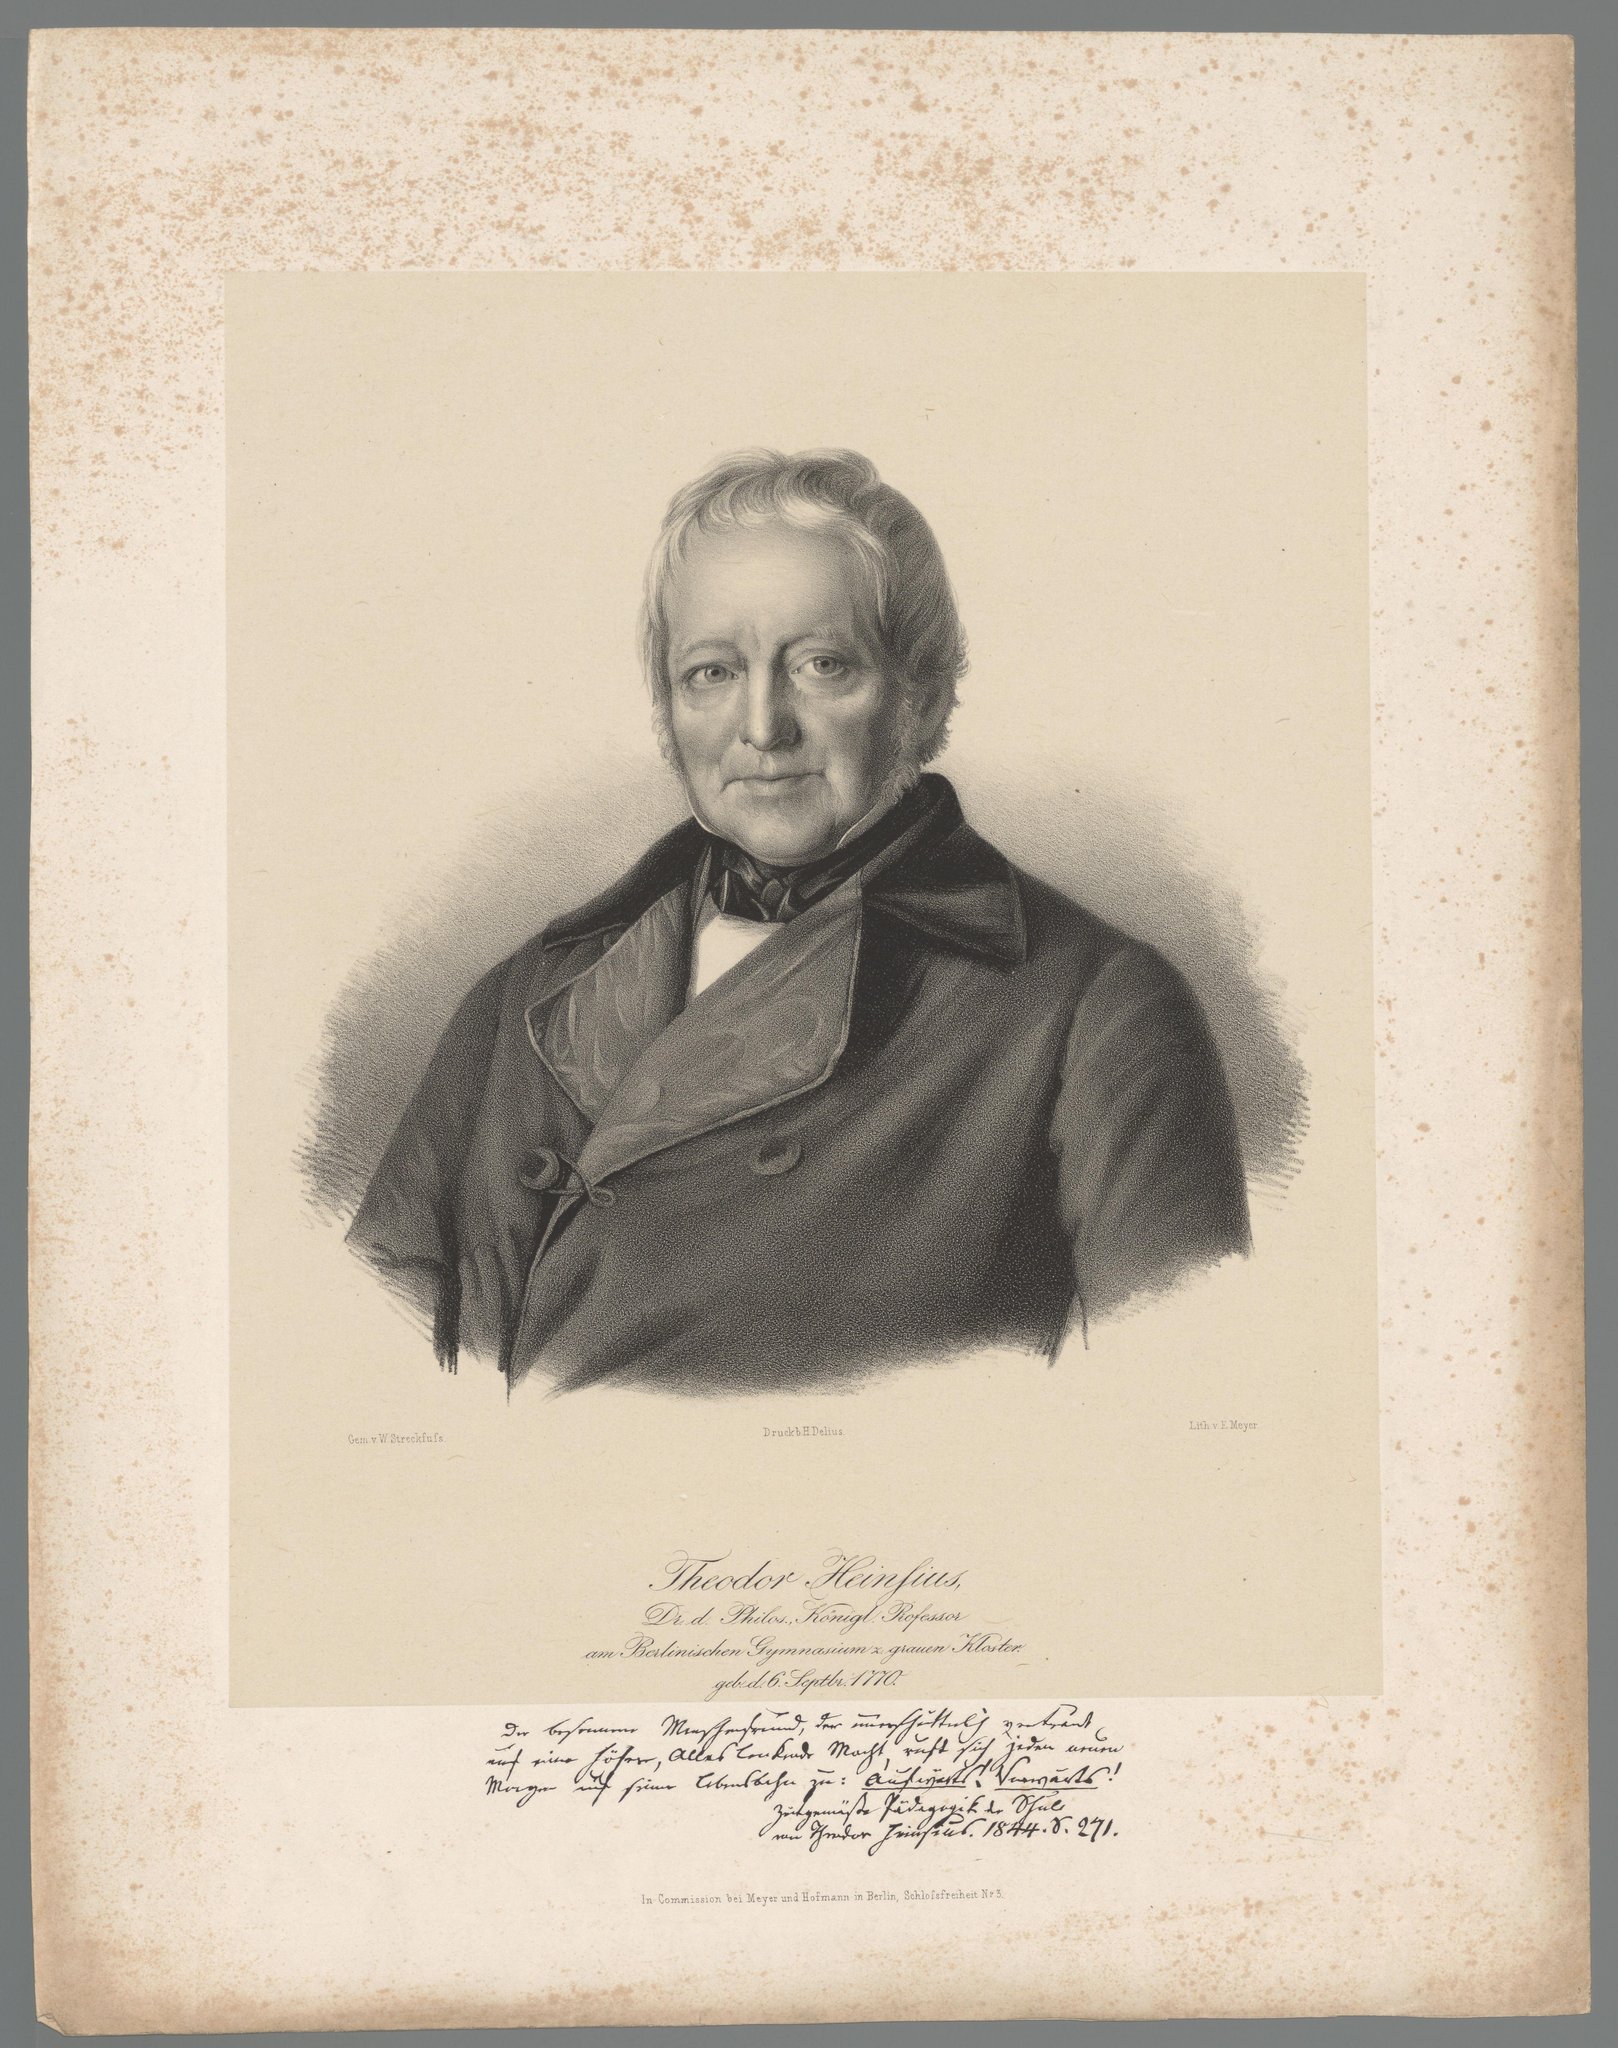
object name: print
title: Theodor Heinsius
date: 1844-1875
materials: paper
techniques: lithograph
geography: berlin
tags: adult man, historical persons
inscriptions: collector's mark: Lugt 2228